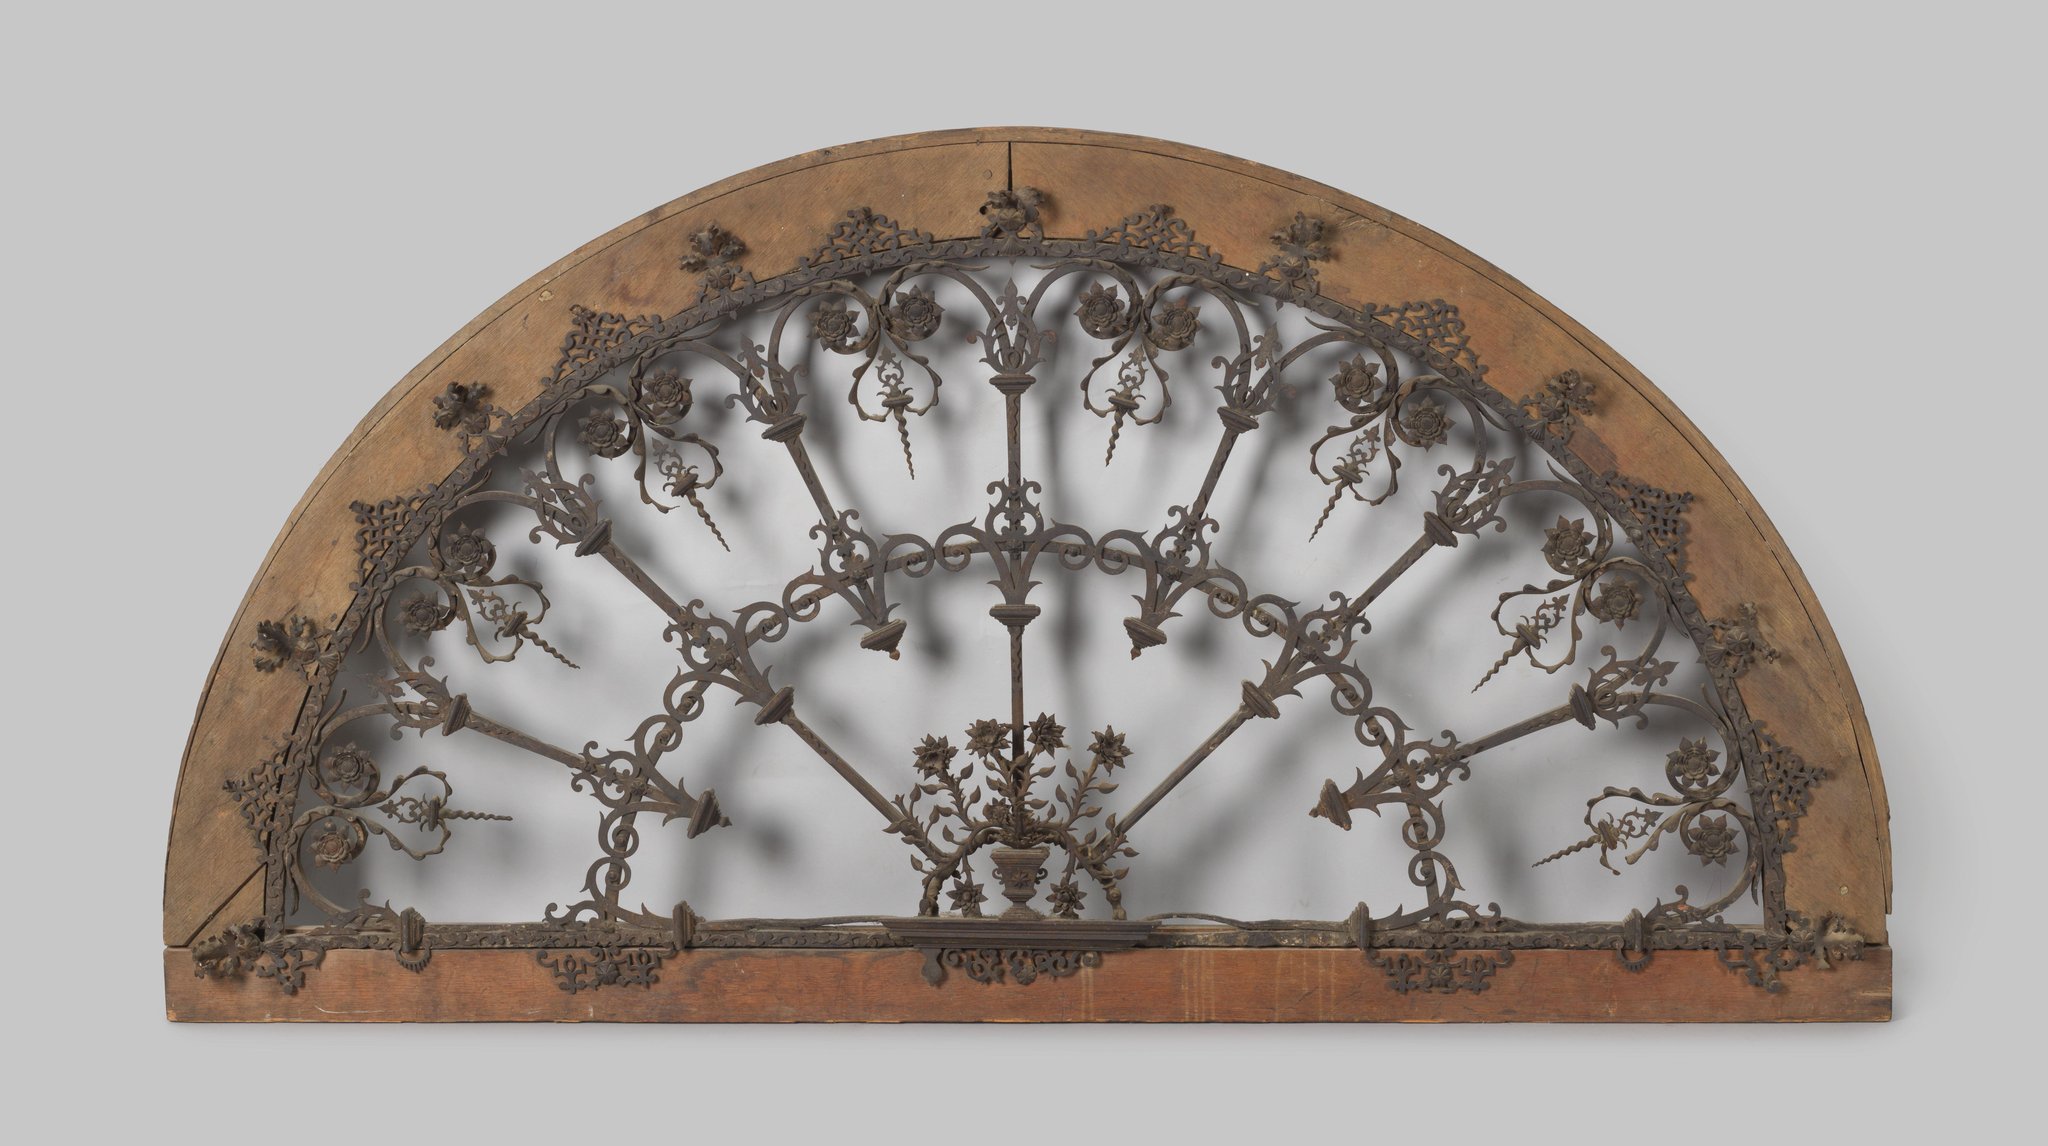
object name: spandrel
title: Boogvulling van ijzer, half cirkelvormig en gevat in eikenhouten raam.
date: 1575-1600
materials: iron, wood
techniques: forging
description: Een gesmeed ijzeren boogvulling, zeer rijk bewerkt en gevat in een eikenhouten, halfcirkelvormig raam.